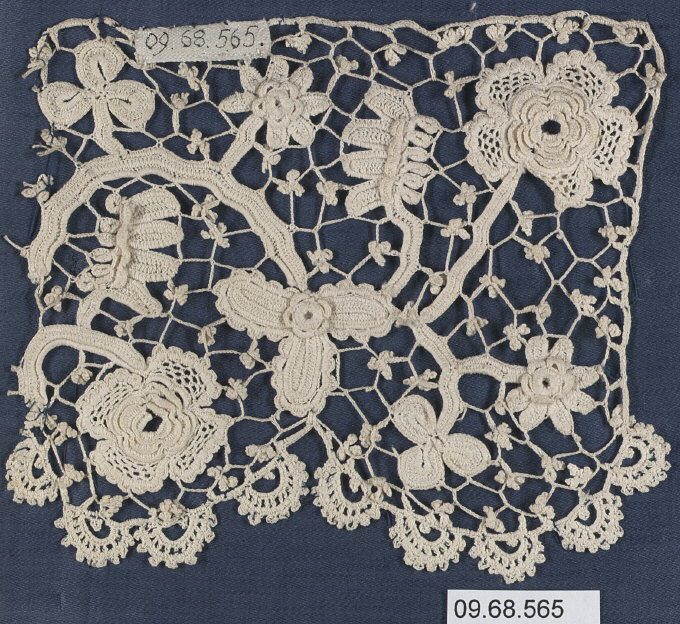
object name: specimen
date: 1801-1900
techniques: crochet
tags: flowers